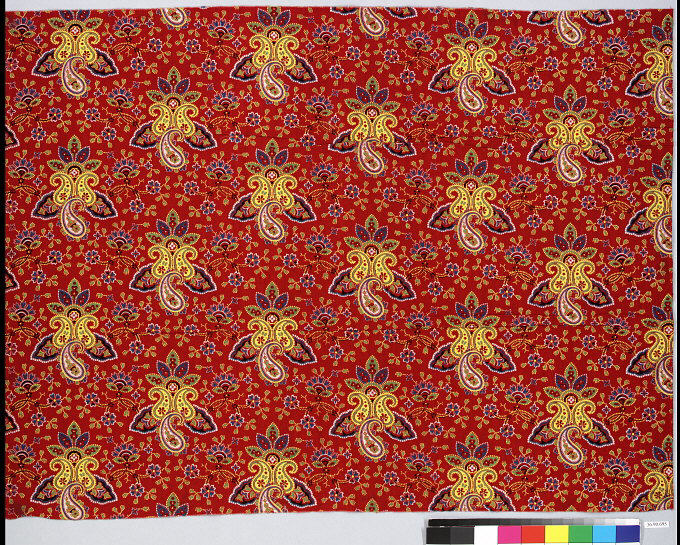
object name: piece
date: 1867-1900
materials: cotton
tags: flowers